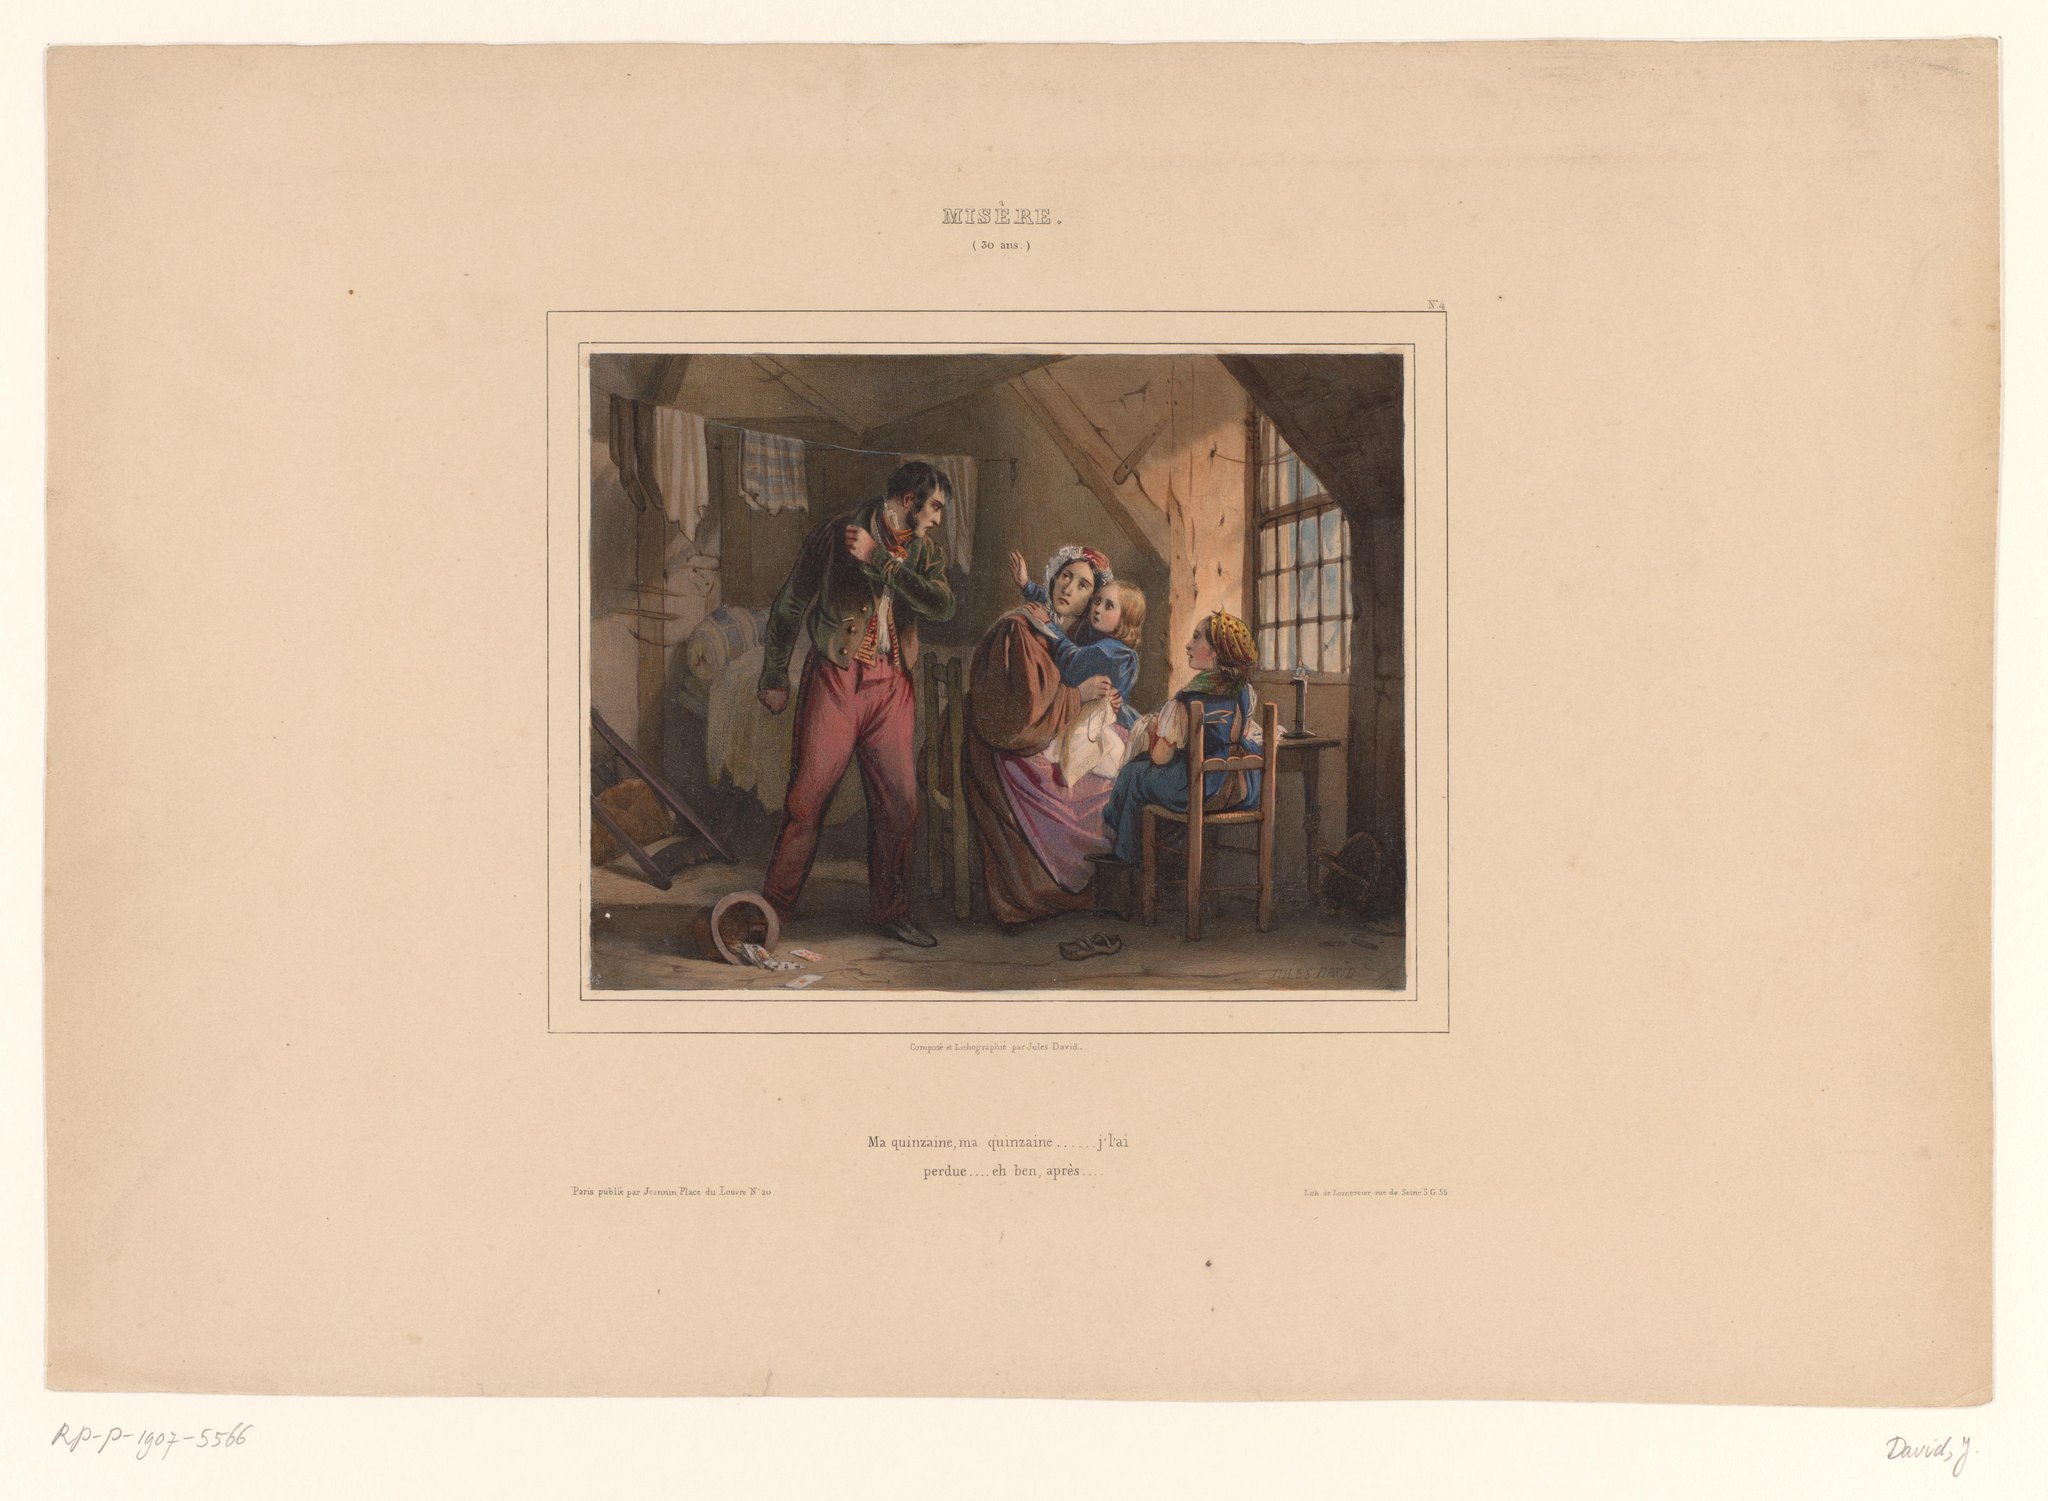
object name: print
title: Deugden en ondeugden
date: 1836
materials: paper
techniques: hand coloring, lithograph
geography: paris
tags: labourers returning home, family life at home, the poor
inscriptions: check stamp: Lugt 1397c, collector's mark: Lugt 2228a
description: Een arme arbeider komt zonder het tweewekelijkse salaris thuis bij zijn gezin. Hij gebruikt de smoes dat hij het geld verloren heeft.